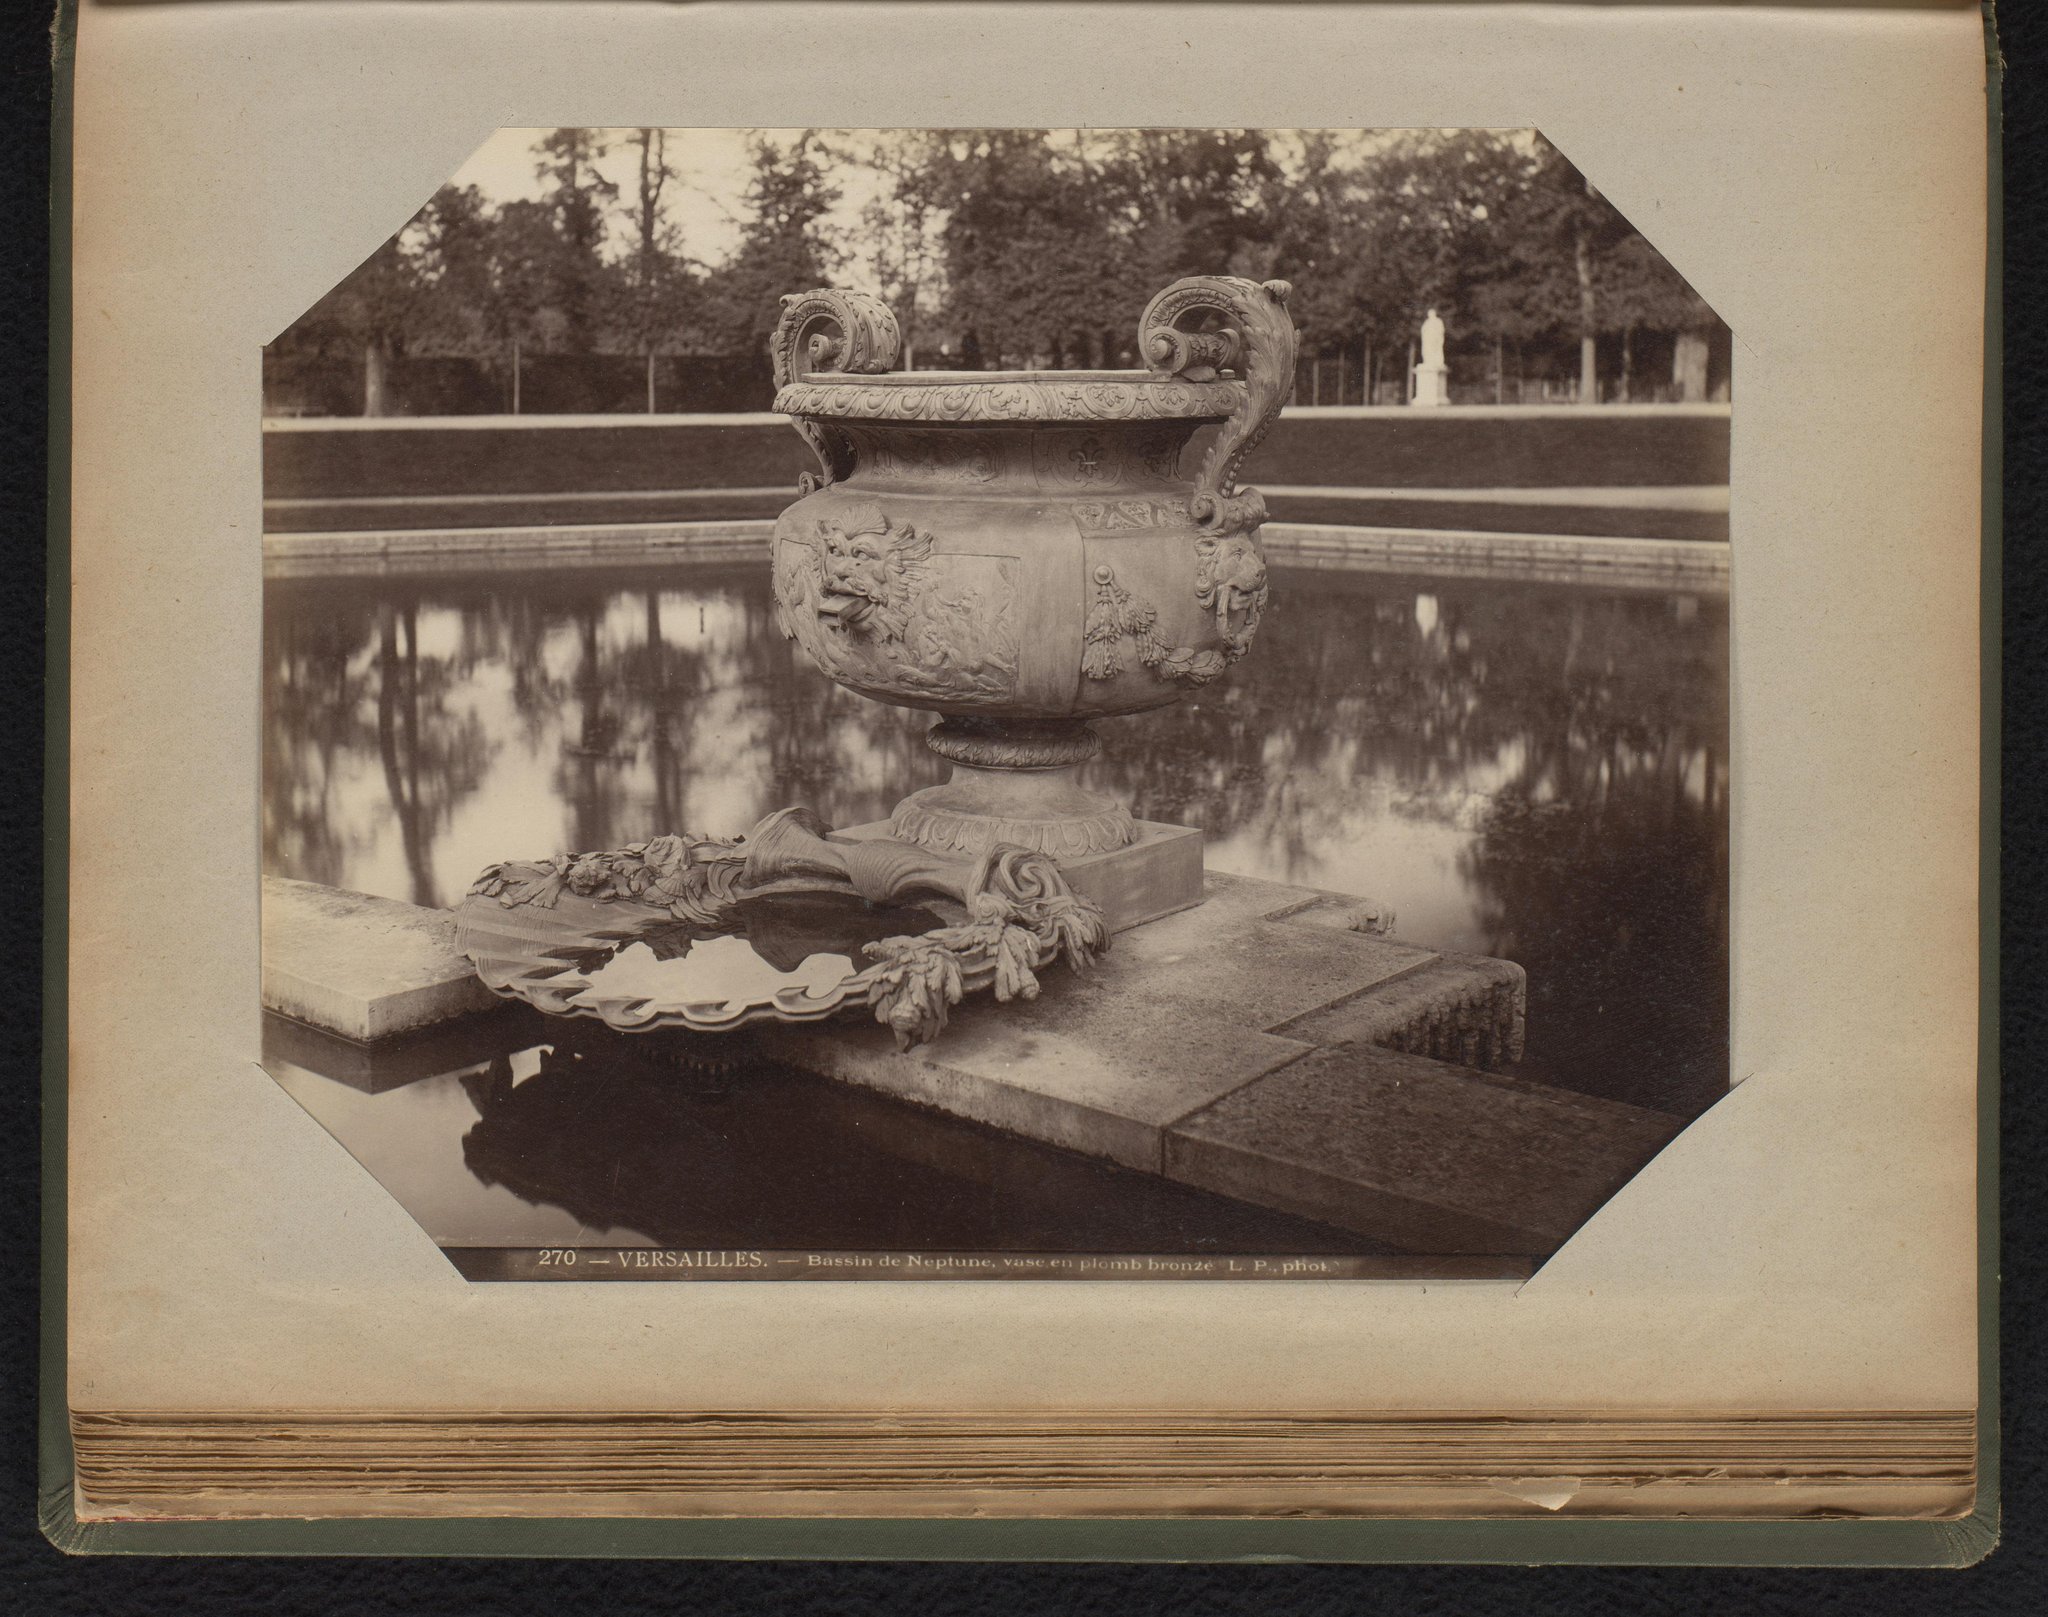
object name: photograph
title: 270 - Versailles - Bassin de Neptune, vase en plomb bronze (L.P. Phot).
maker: Anonymous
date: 1860-1900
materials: paper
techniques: albumen print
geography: france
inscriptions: annotation: ‘268 - Versailles - Bassin de Neptune, vase en plomp bronze L.P. Phot.’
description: Onderdeel van een serie met betrekking tot het interieur van het paleis van Versailles met kroonluchters, deuren, portalen en meubelstukken.